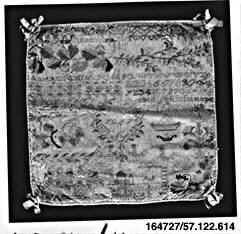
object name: sampler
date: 1811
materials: silk, wool